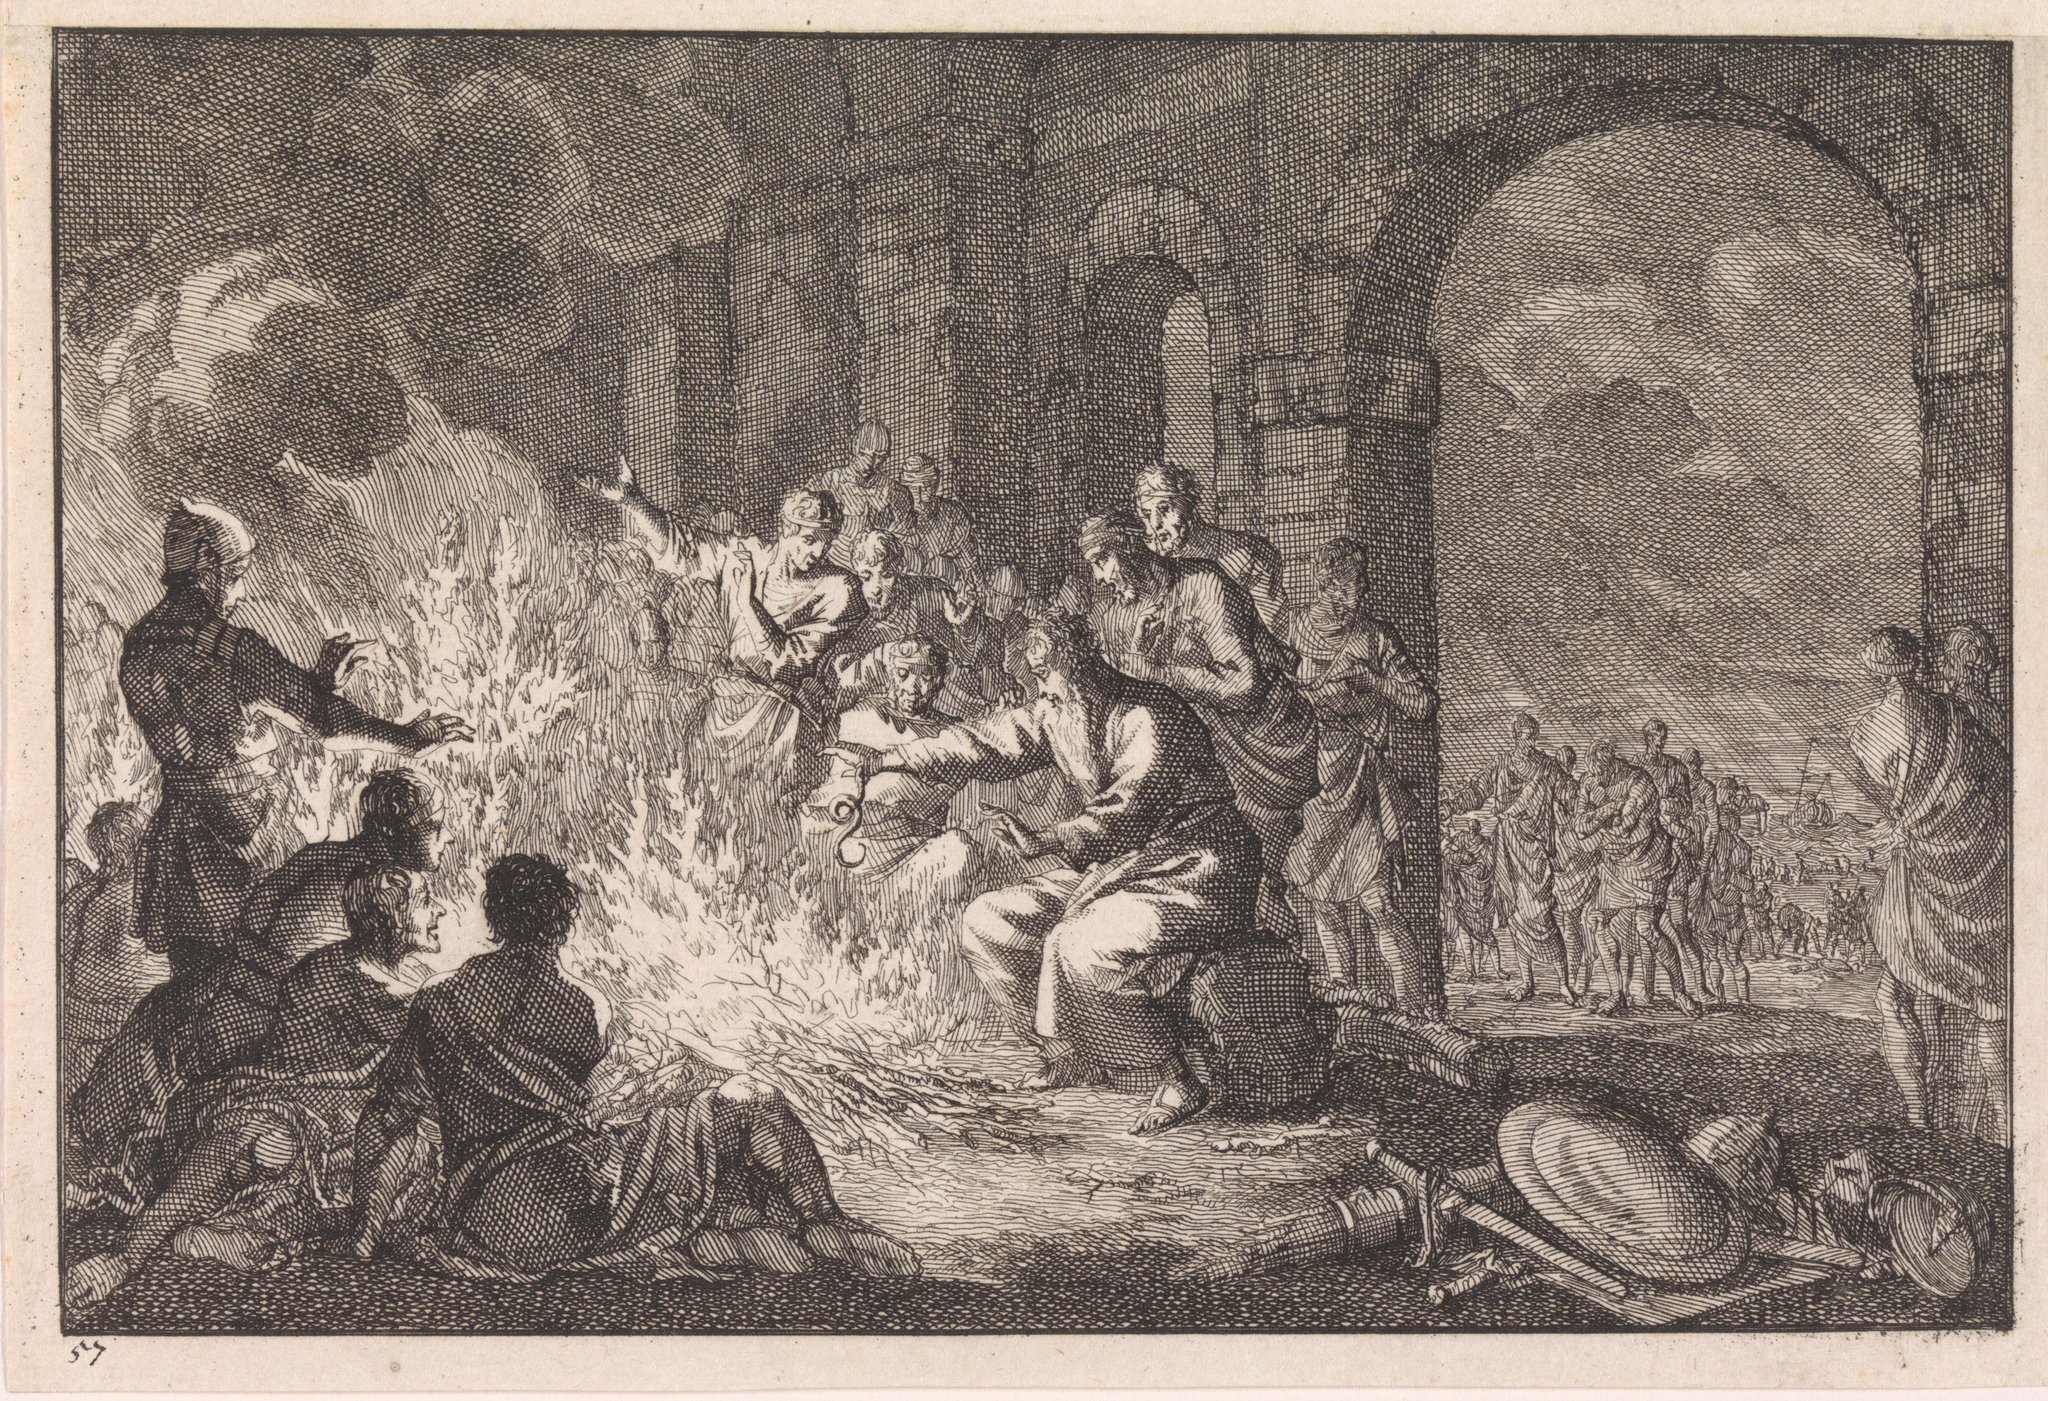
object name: print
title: Paulus wordt in Malta gebeten door een adder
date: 1703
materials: paper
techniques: etching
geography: haarlem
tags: paul bitten by a viper (when throwing wood on the fire)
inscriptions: collector's mark: Lugt 2228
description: Proefdruk van een boekillustratie voor David Martin. Historie des Ouden en Nieuwen Testaments. Amsterdam, Pieter Mortier, 1703. Deel II. De boekillustraties voor de Mortierbijbel hebben verschillende staten en kopieën, waarbij de chronologische volgorde moeilijk te achterhalen valt. Als boekillustraties werden ze bovendien herhaaldelijk opnieuw gebruikt voor andere boekwerken.